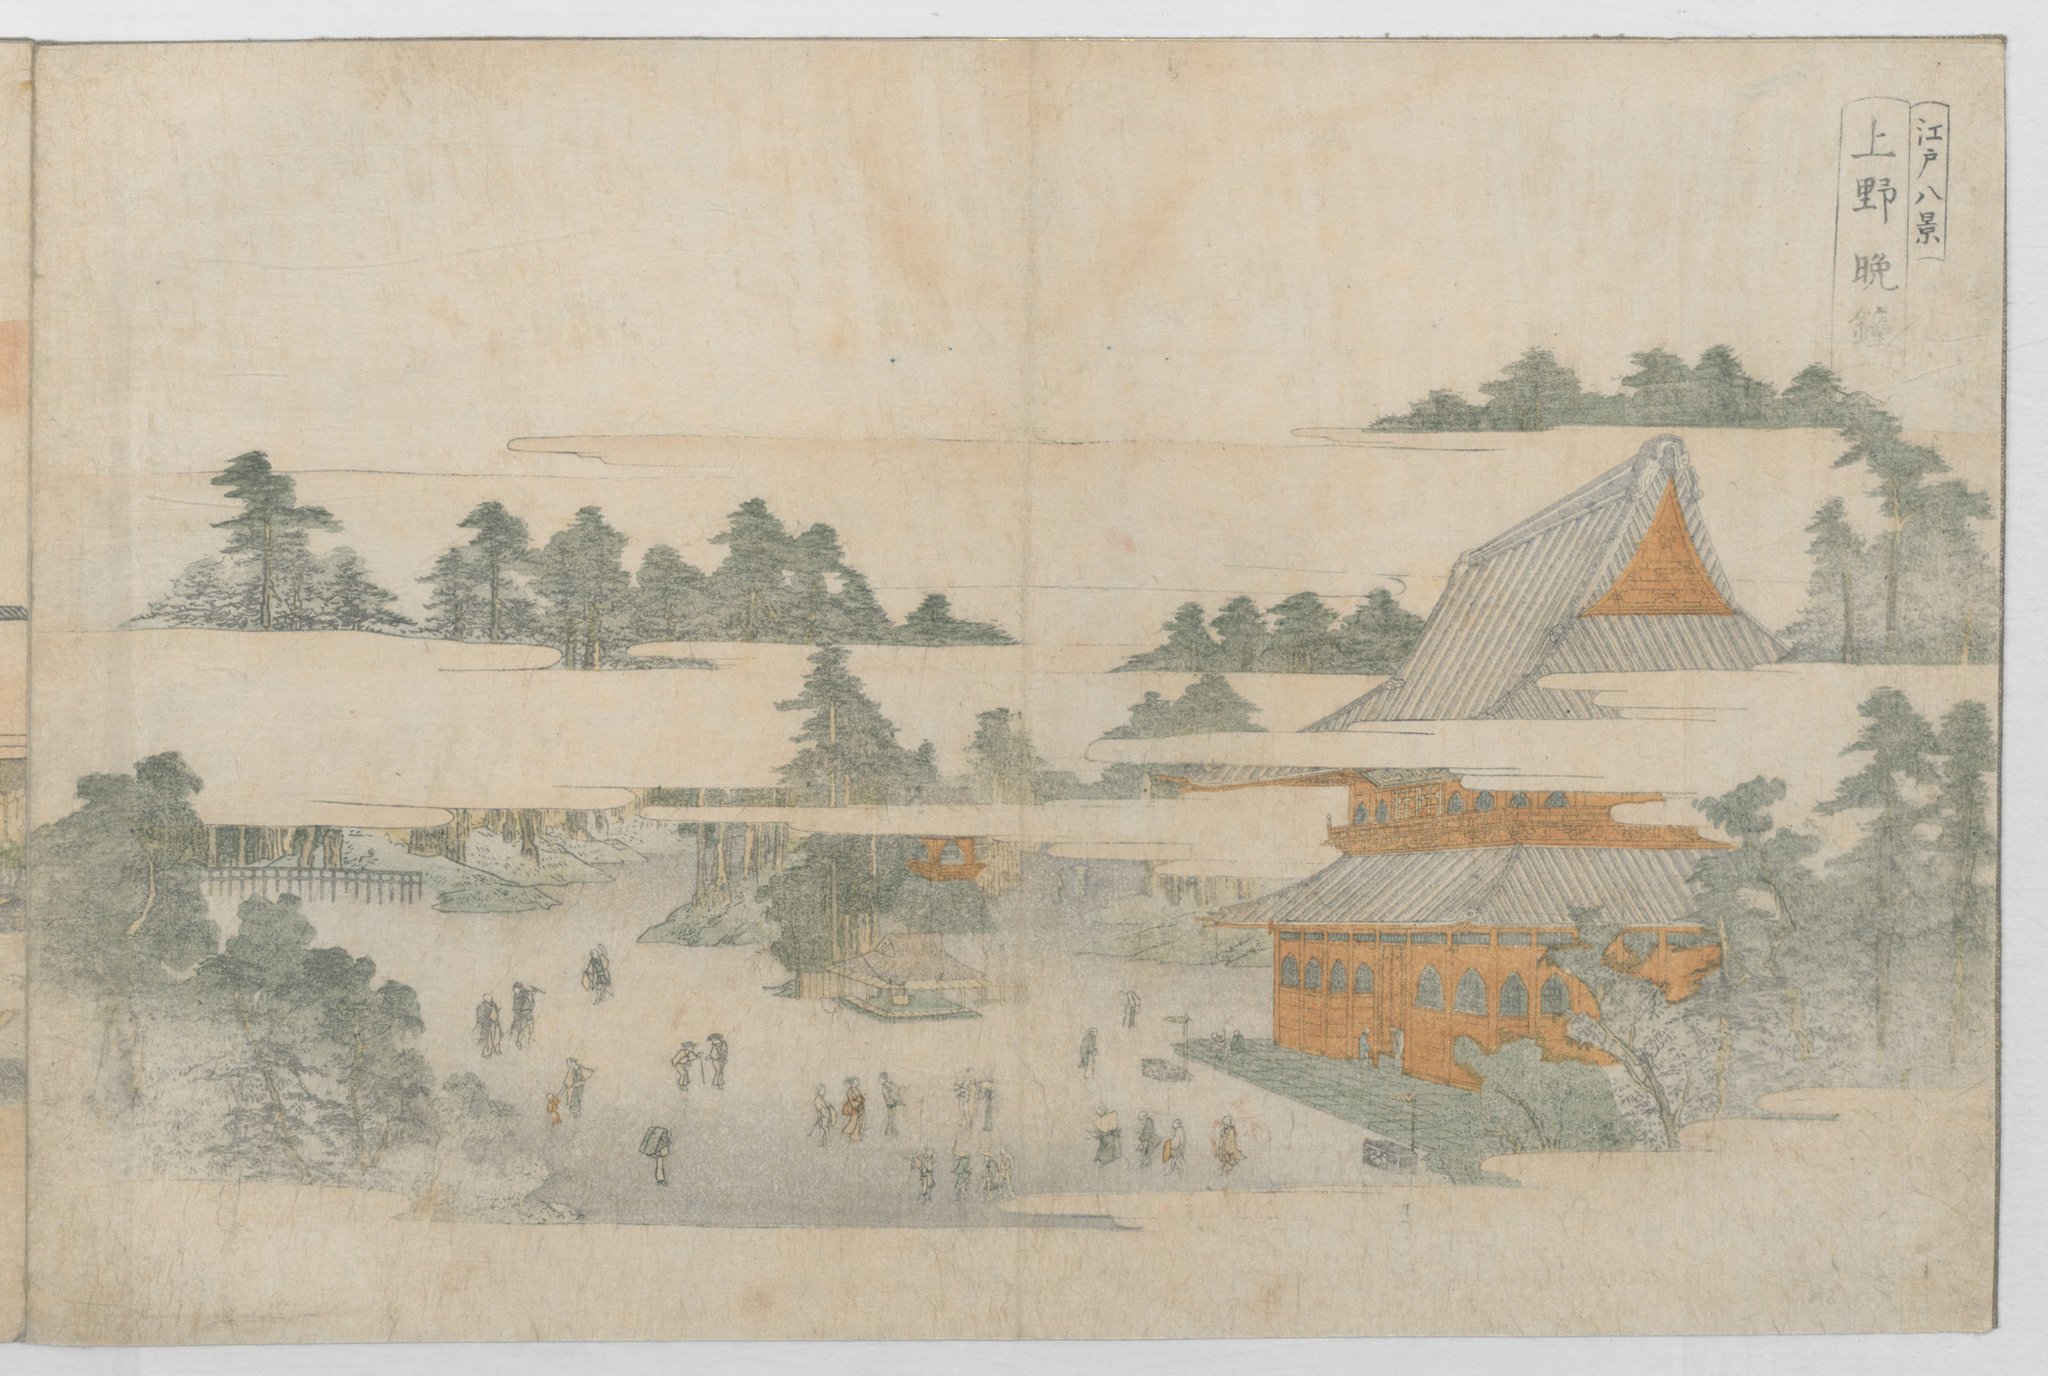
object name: illustrated book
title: Eight Views of Edo (Edo Hakkei) 江戸八景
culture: japanese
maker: utagawa toyohiro (ichiryūsai) 歌川 (一柳斎) 豊広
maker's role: artist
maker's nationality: japanese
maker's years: 1763-1828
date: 1771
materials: ink, paper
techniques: bookbinding, polychrome, woodblock print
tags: human figures,houses,cities,landscapes,trees